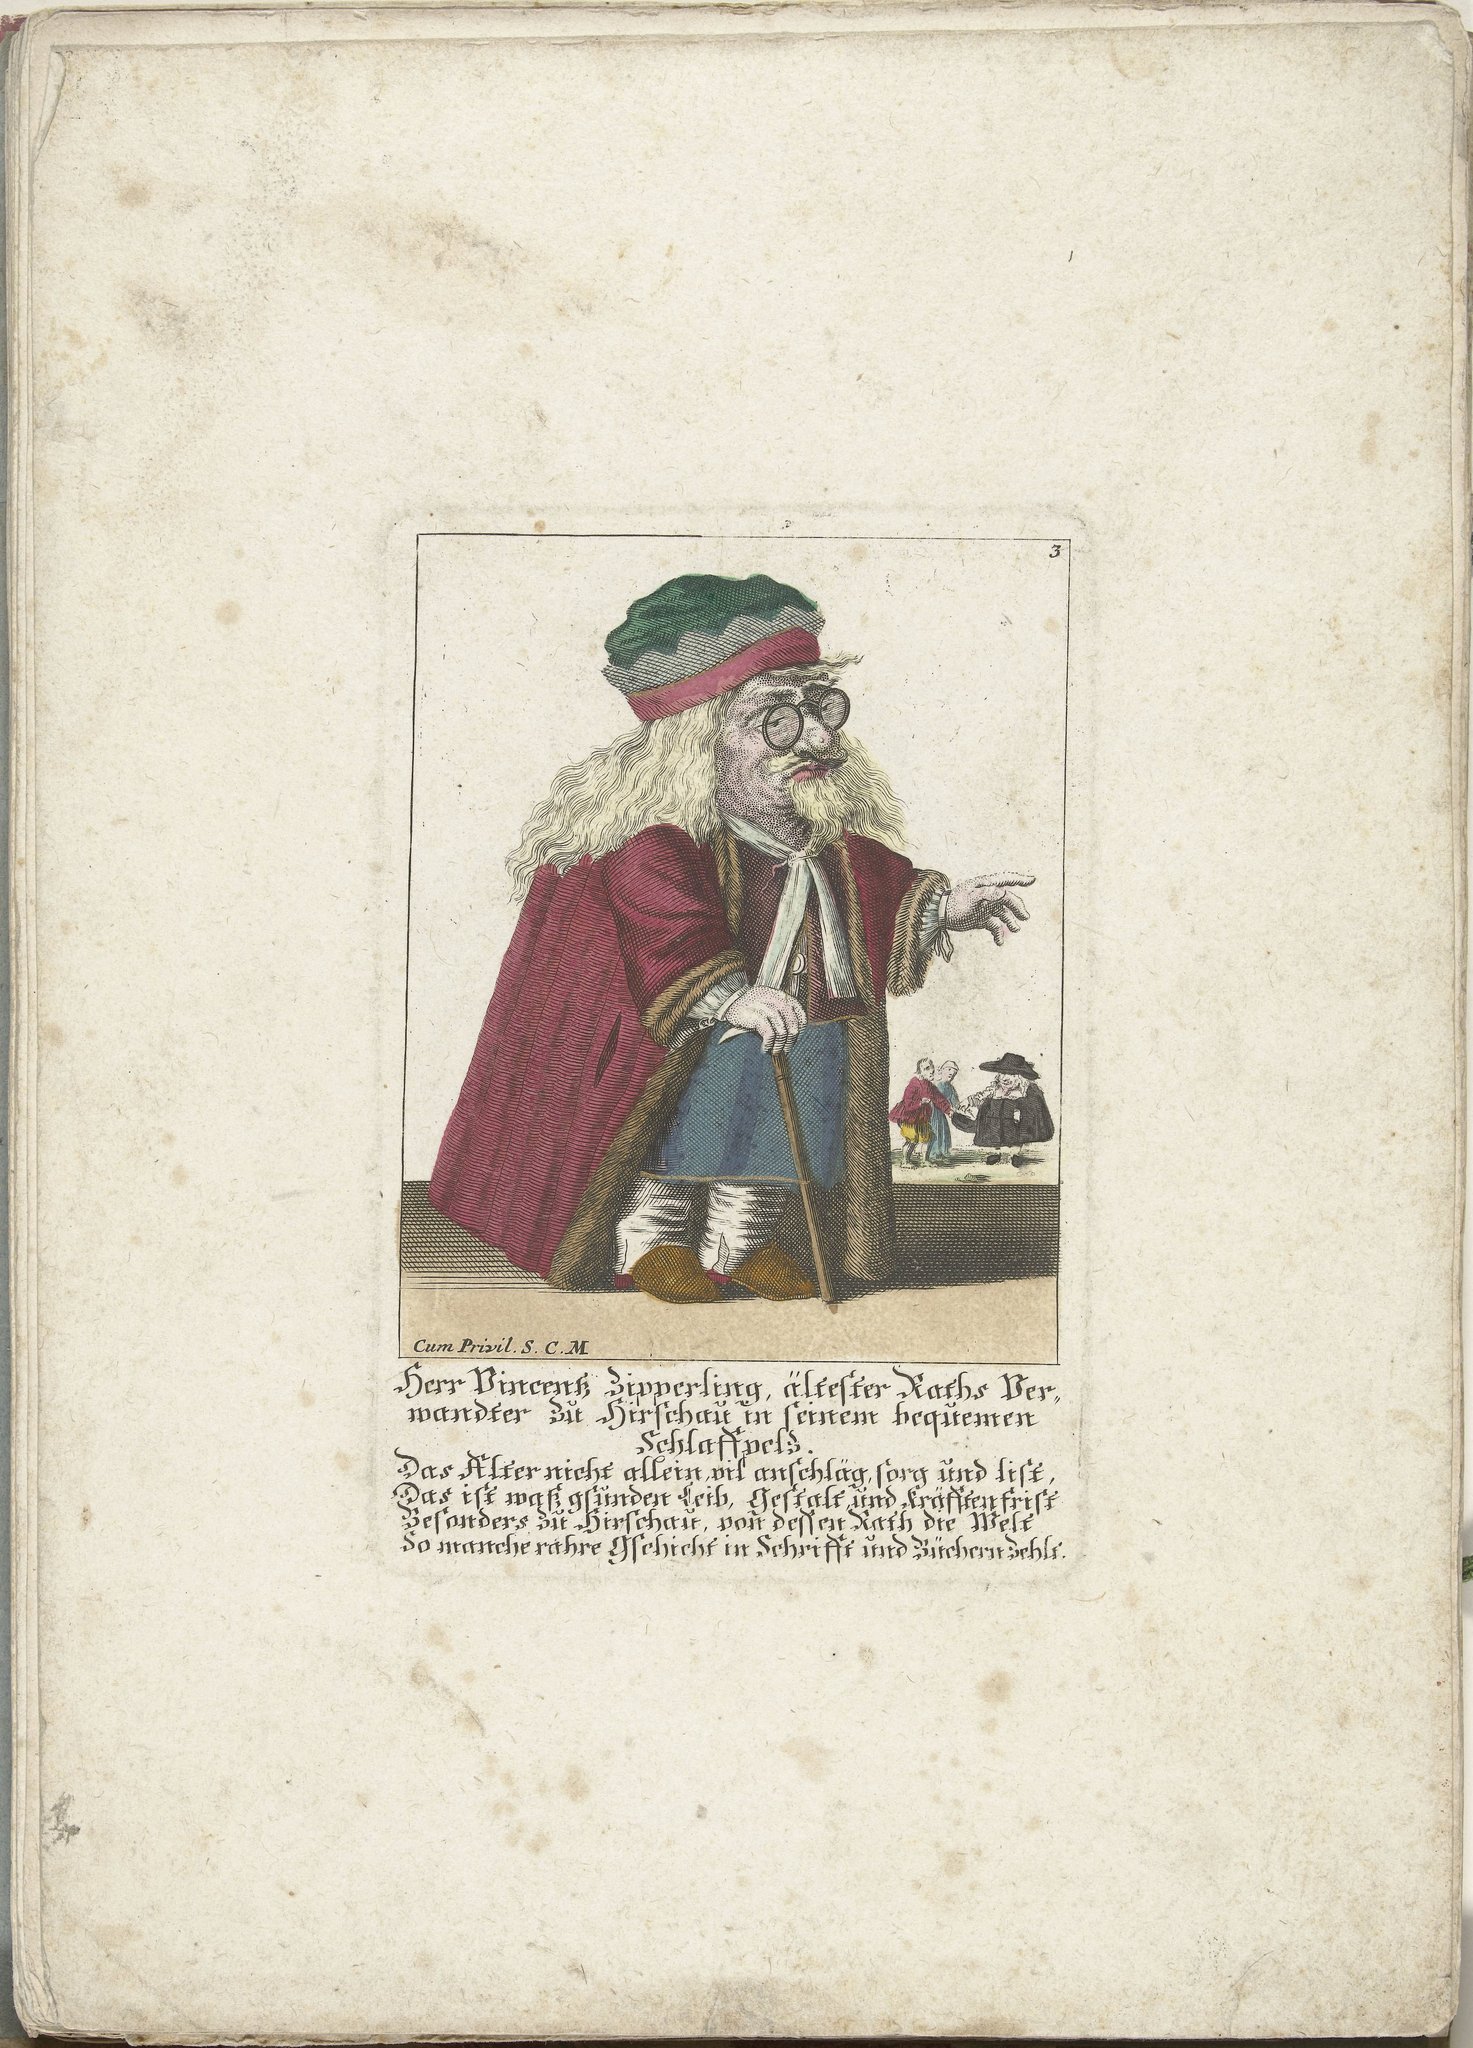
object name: caricature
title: De kleine mens Vincentz Zipperling in een bontjas, ca. 1710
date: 1705-1715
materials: paper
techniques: engraving, etching, hand coloring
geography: augsburg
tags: caricatures (human types), little people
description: De kleine mens Vincentz Zipperling in een bontjas. In het onderschrift onder de titel een vierregelig vers in het Duits. Genummerd rechtsboven: 3. Onderdeel van een losbladige uitgave uit ca. 1710 van een serie karikaturen van kleine mensen, bekend als Het Dwergentooneel.